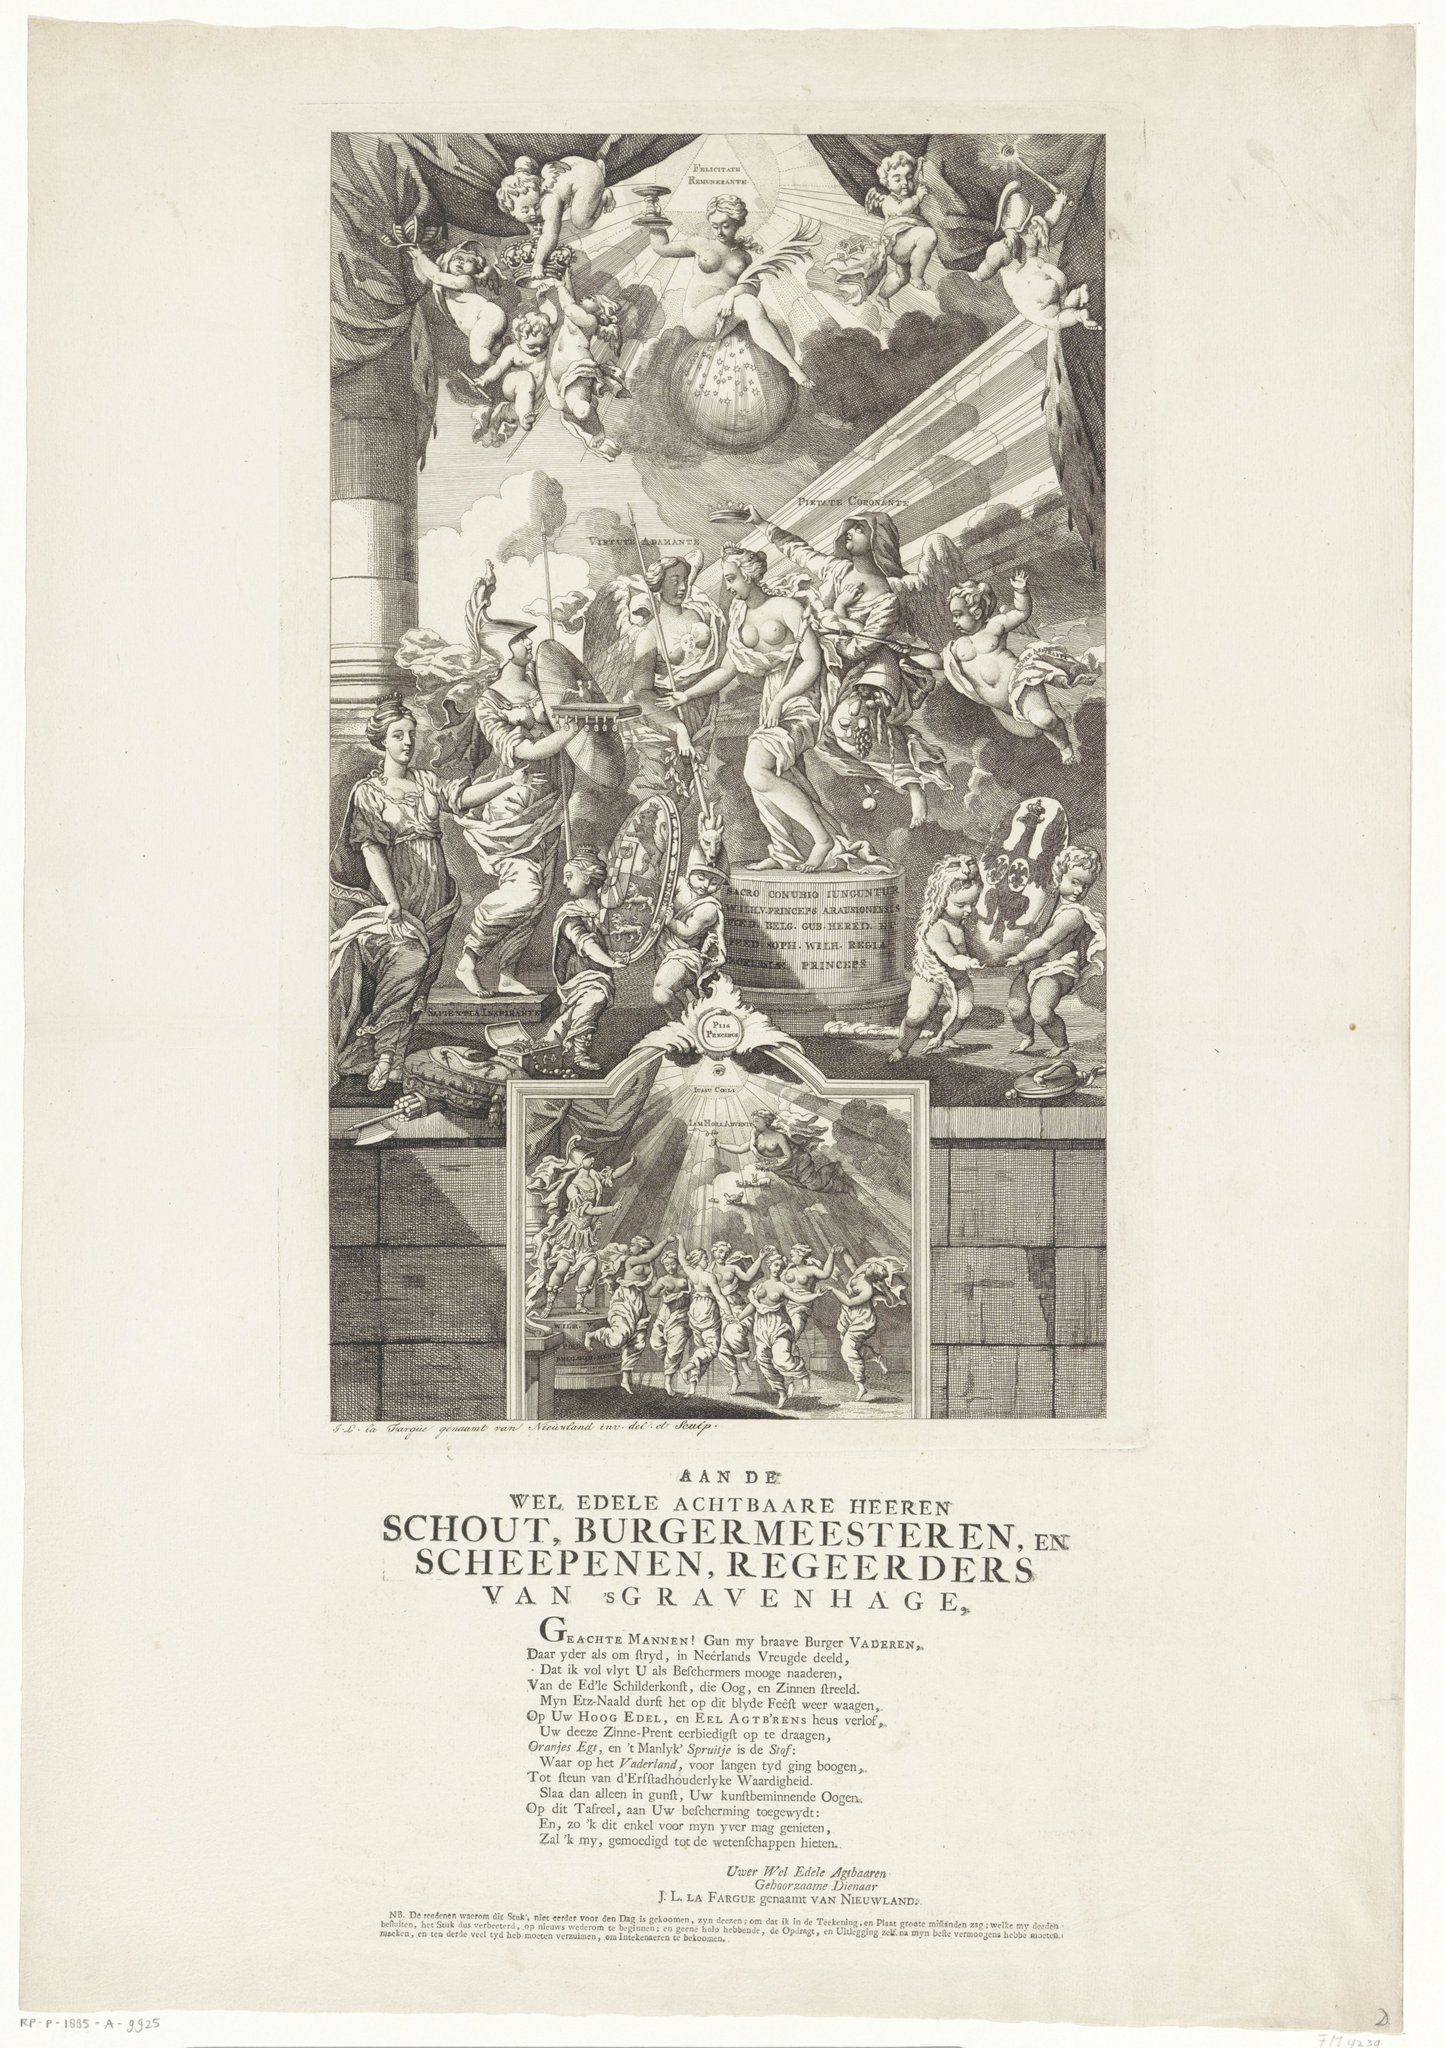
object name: print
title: Allegorie op het huwelijk van Willem V en Wilhelmina van Pruisen in 1767 en de geboorte van prins Willem Frederik in 1772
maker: isaac lodewijk la fargue van nieuwland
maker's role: draughtsman, painter, print maker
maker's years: 1726-1805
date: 1772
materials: paper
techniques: engraving, etching, letterpress printing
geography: the hague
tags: william v (prince of orange), the hague, william i of the netherlands, berlin, painter, draughtsman, wilhelmina of prussia (princess of orange), fertility, personification of a city, town-patron(ess), marriage, married couple, 'matrimonium', specific aspects, allegorical aspects of minerva; minerva as patroness, piety, 'pietas', 'timor dei' ~ the three theological virtues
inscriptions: collector's mark: Lugt 2228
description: Allegorie op het huwelijk van Willem V en Wilhelmina van Pruisen in 1767 en de geboorte van prins Willem Frederik op 24 augustus 1772. Twee voorstellingen: bovenaan een allegorie waarin de prinses staande op een voetstuk het verzegelde boek van huwelijksgeluk aangereikt krijgt van de Wijsheid (Minerva). Hierbij ook de Deugd en de stedenmaagd van Den Haag. De prinses wordt gekroond door de Vroomheid. In een kleinere voorstelling onderaan dansen zeven halfnaakte vrouwen, provinciemaagden(?), voor prins Willem V ter gelegenheid van de geboorte van de prins Willem Frederik. Op het blad onder de plaat de opdracht aan de magistraat van Den Haag in een vers van veertien regels.